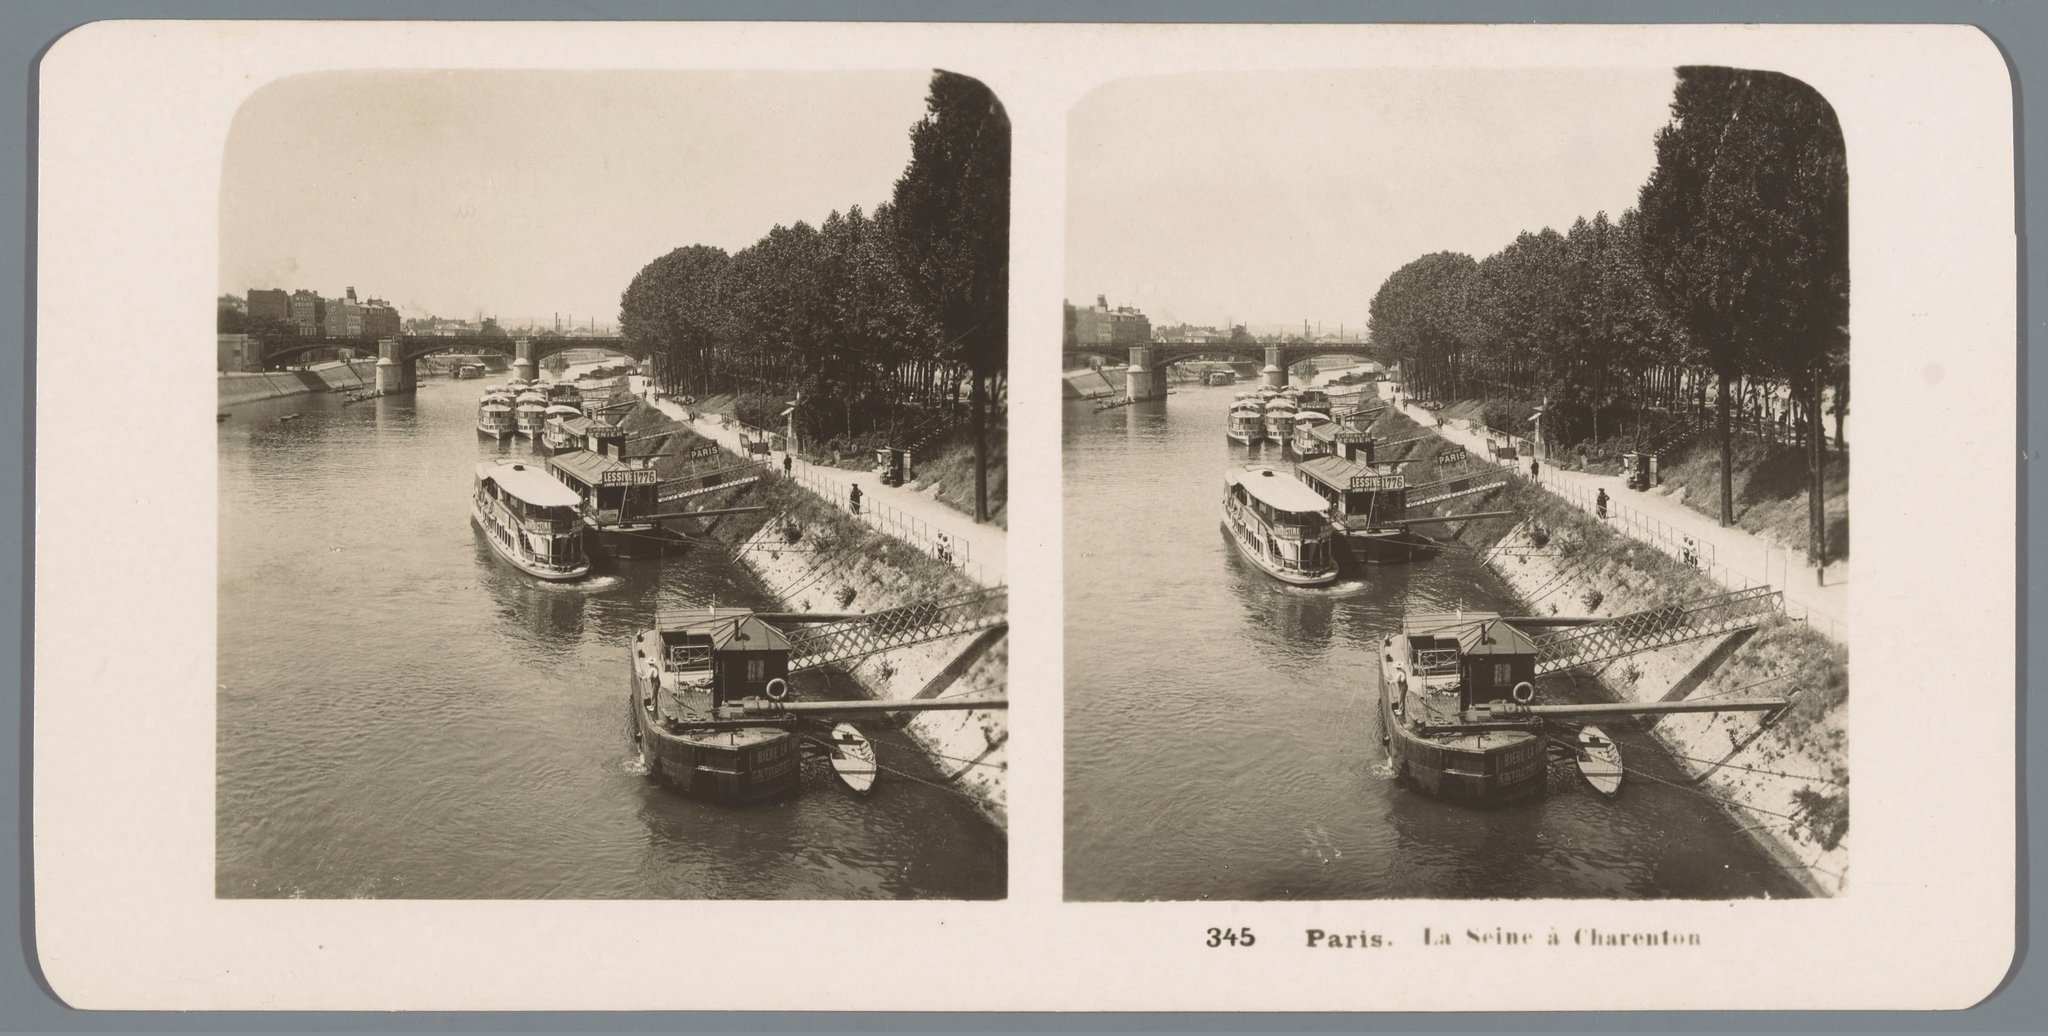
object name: stereograph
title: Gezicht op de Seine te Charenton-le-Pont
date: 1906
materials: cardboard, photographic support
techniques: gelatin silver print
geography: charenton-le-pont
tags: river, boat propelled by man or animal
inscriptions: number: ‘345’, inscription: ‘Neue Photographische Gesellschaft A.-G. Steglitz-Berlin 1906.’